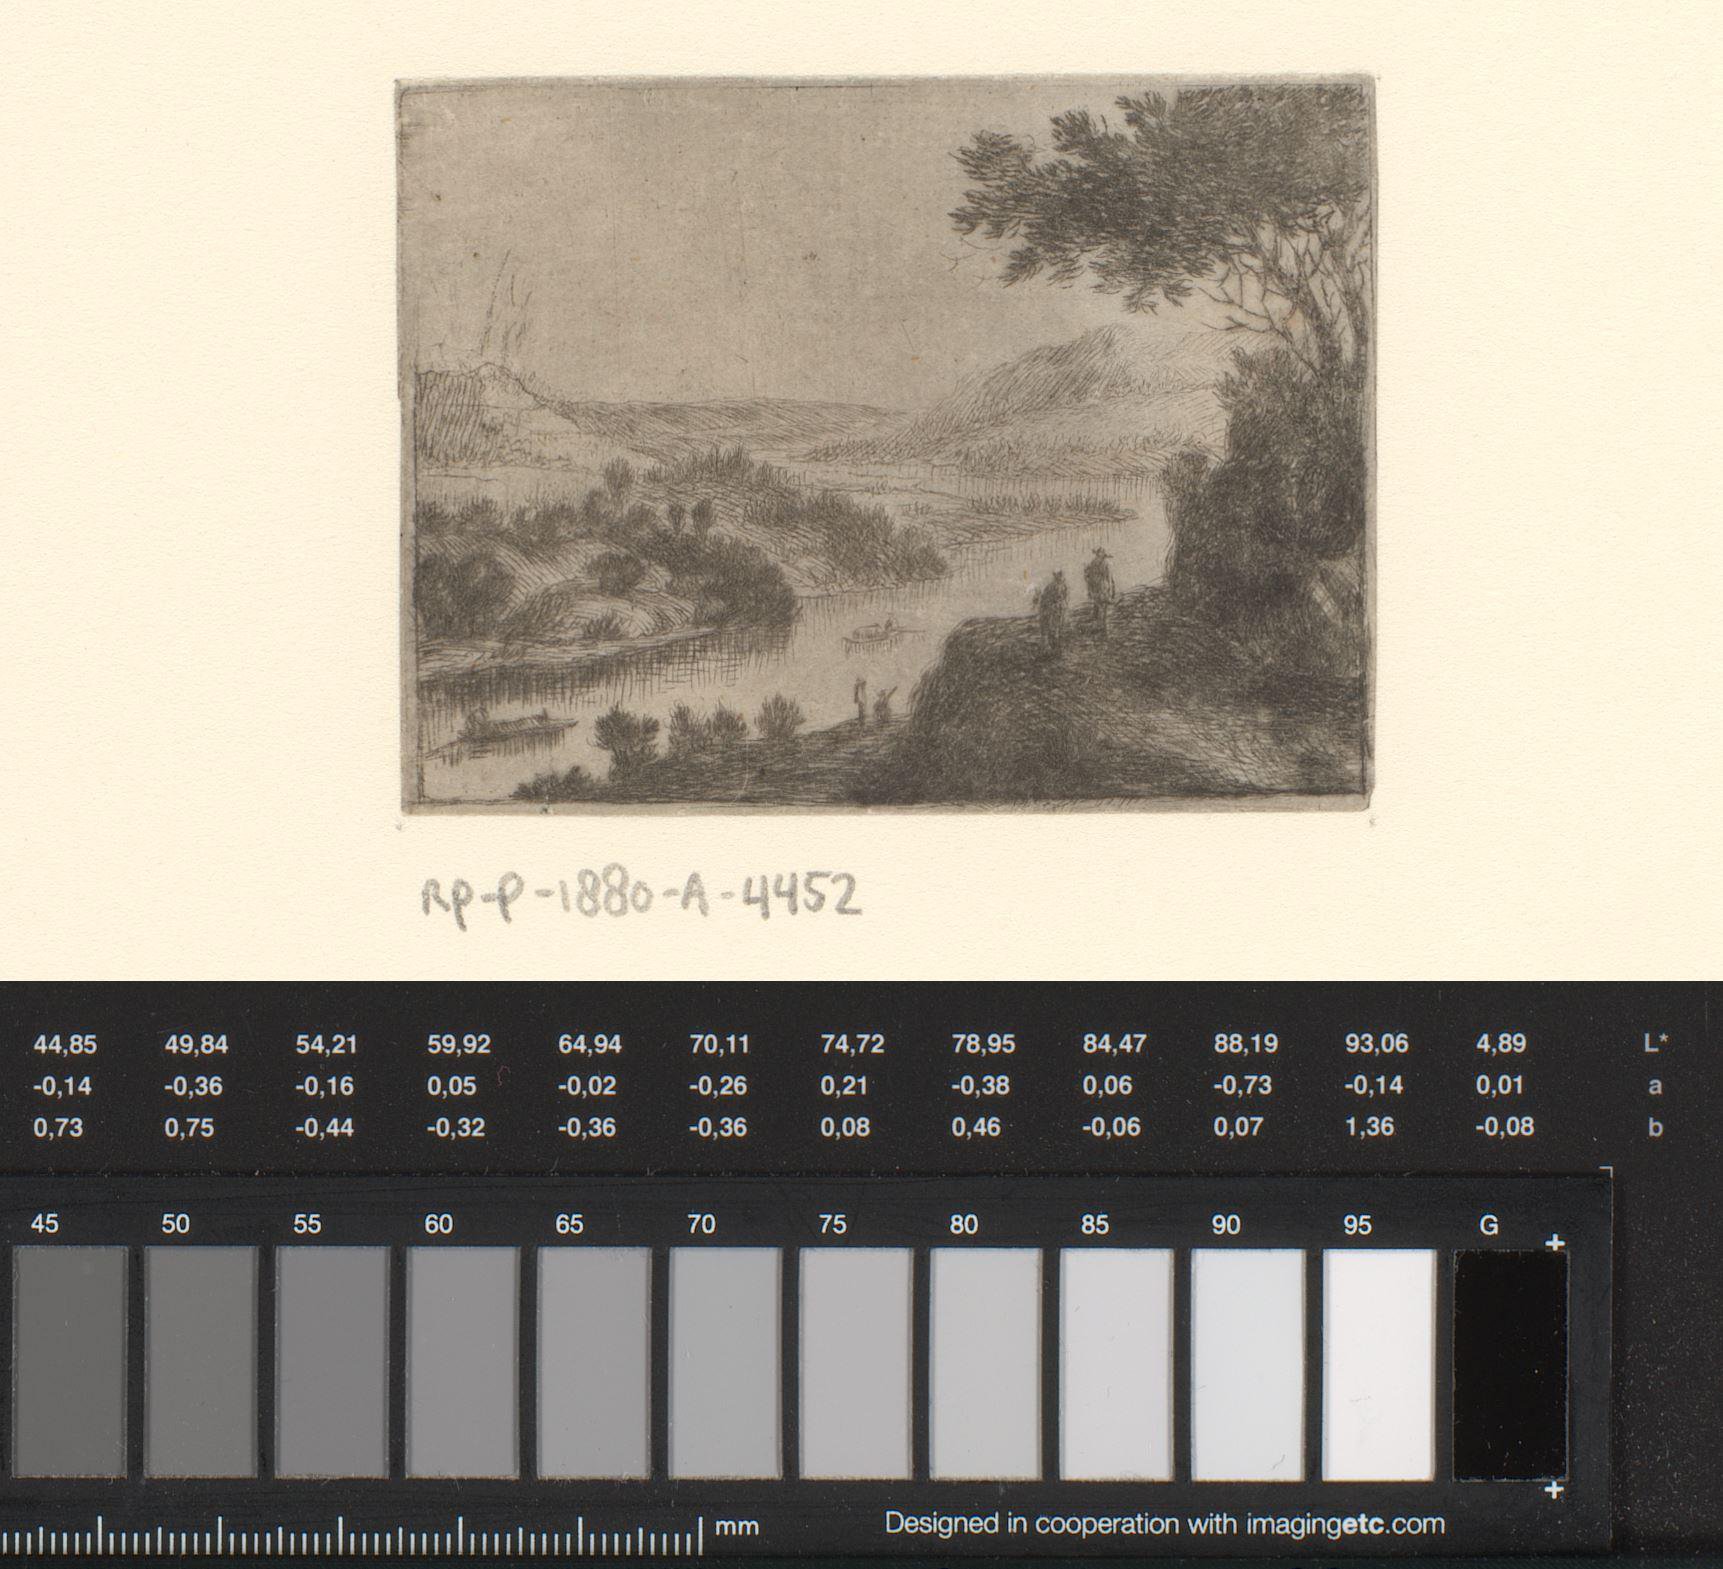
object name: print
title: Heuvelachtig landschap met rivier en twee roeiboten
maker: herman saftleven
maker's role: draughtsman, painter, print maker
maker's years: 1609-1685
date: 1619-1685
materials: paper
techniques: etching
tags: river, (high) hill, rowing-boat, canoe, etc.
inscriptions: collector's mark: Lugt 2227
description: Anonieme prent, van dezelfde hand als RP-P-1881-A-4727.